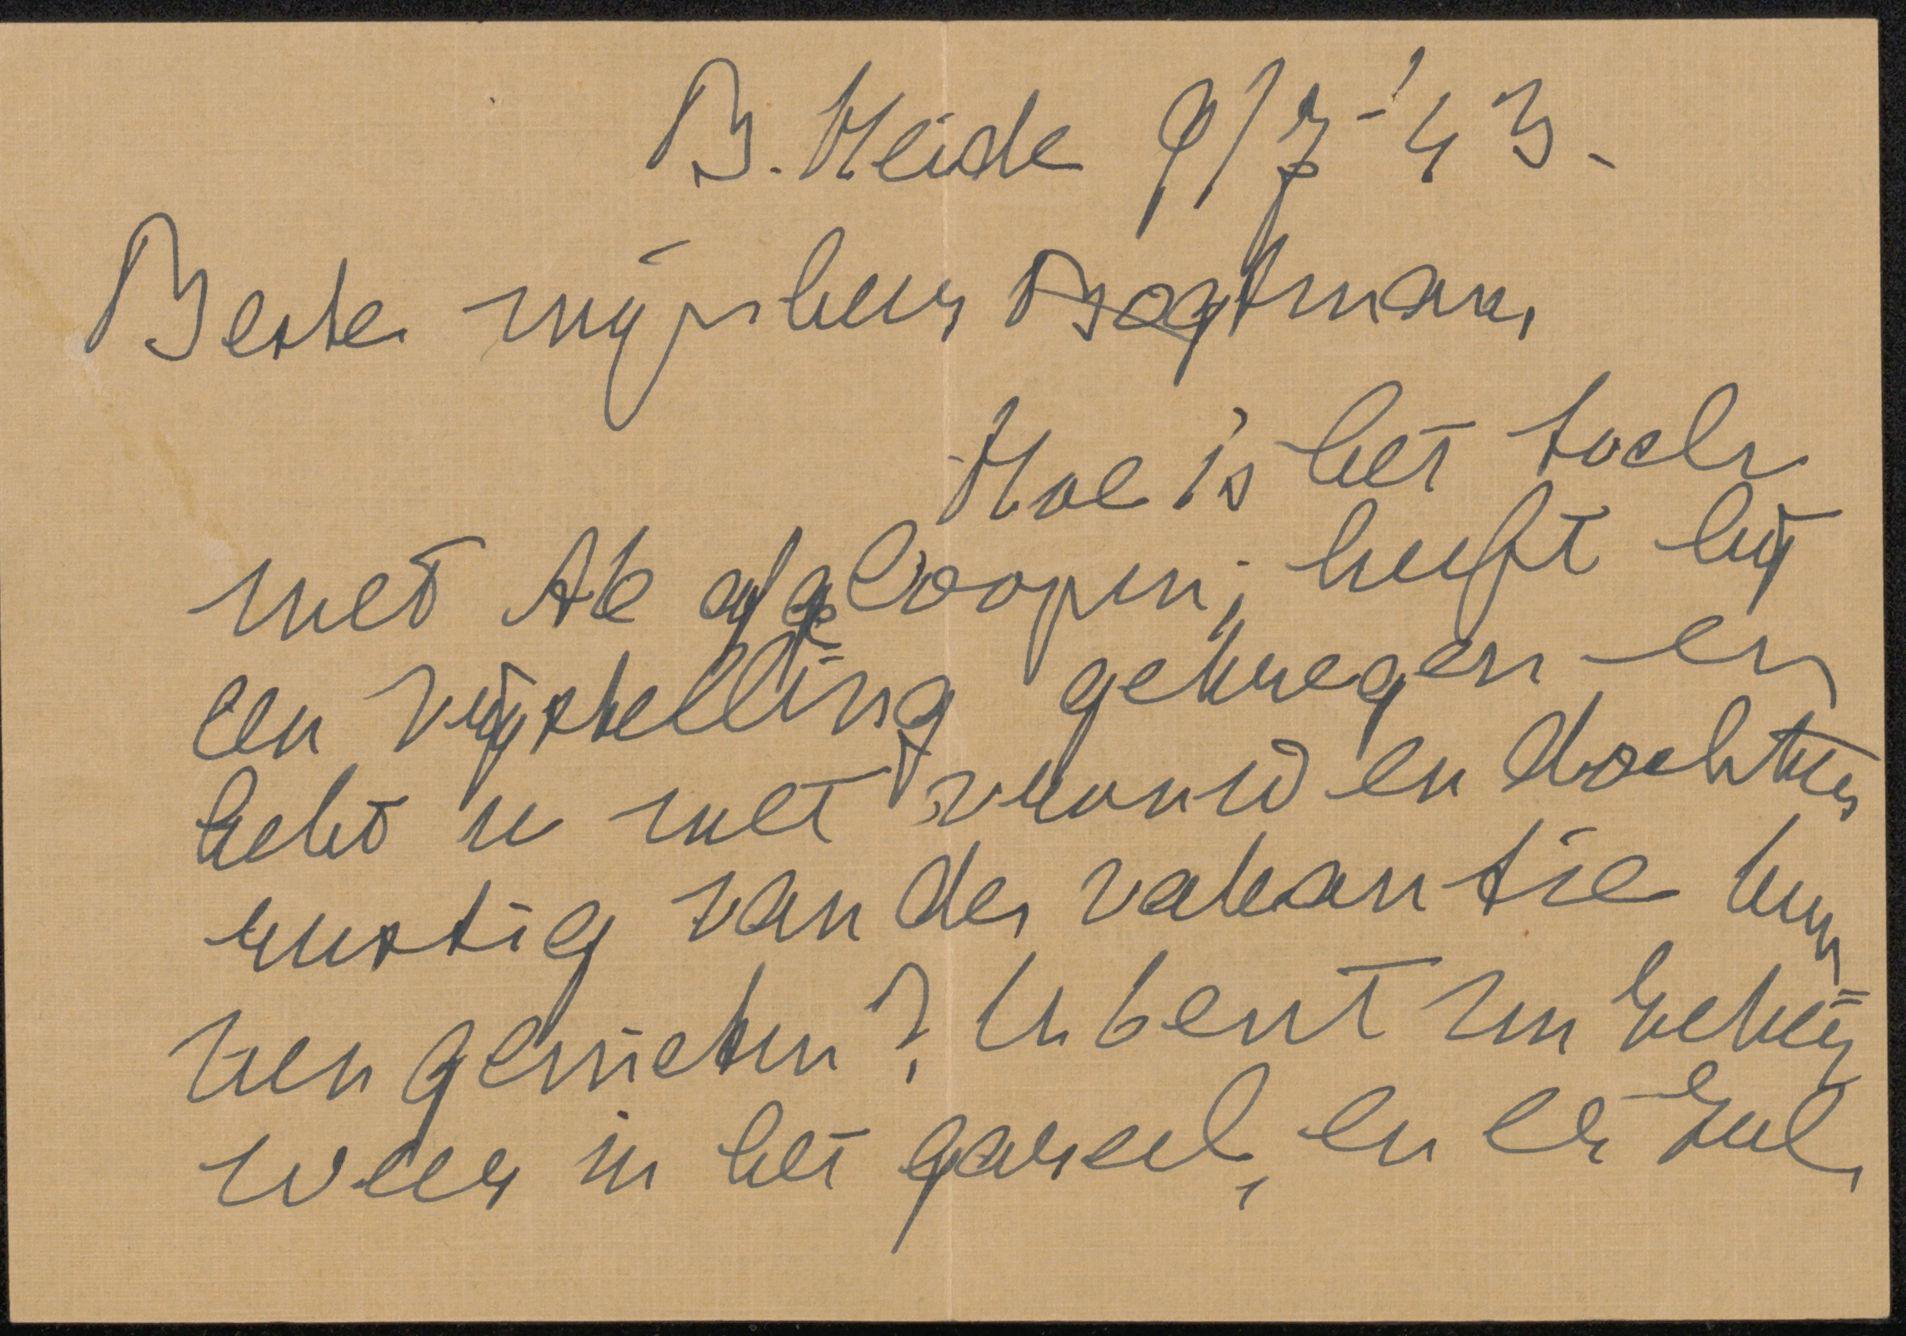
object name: letter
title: Brief aan Willem Bogtman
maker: henriëtte roland holst-van der schalk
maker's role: dichter, schrijver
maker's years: 1869-1952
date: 1943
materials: cardboard, ink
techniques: pen, writing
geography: buissche heide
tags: haarlem, willem bogtman, richard nicolaüs roland holst, the graphic arts